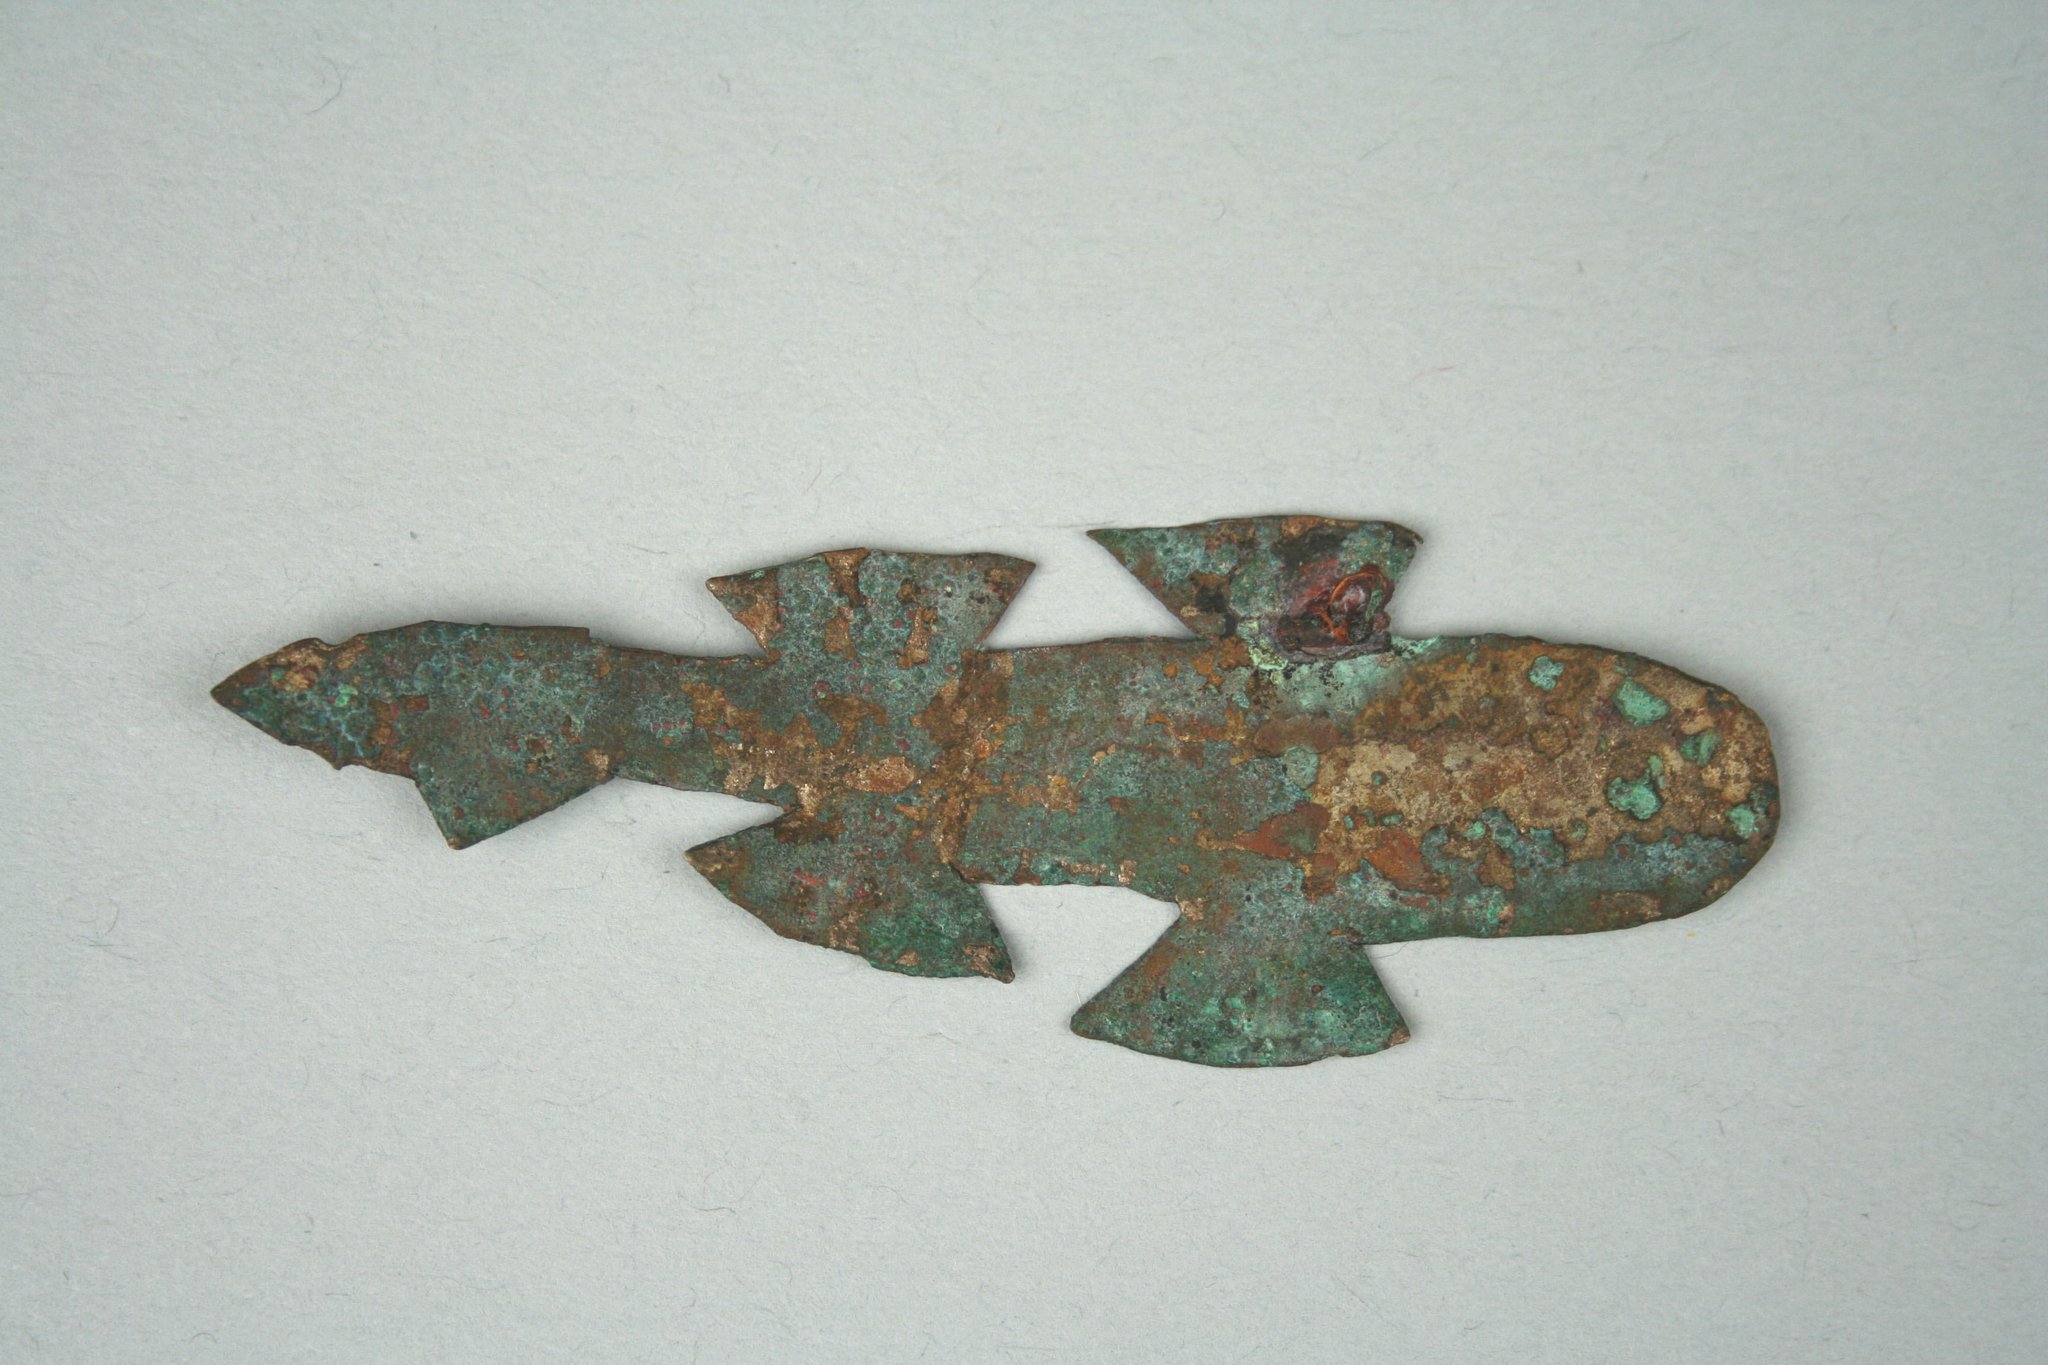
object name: ornament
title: Fish Ornament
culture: peruvian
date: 1001-1200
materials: silver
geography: peru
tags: fish